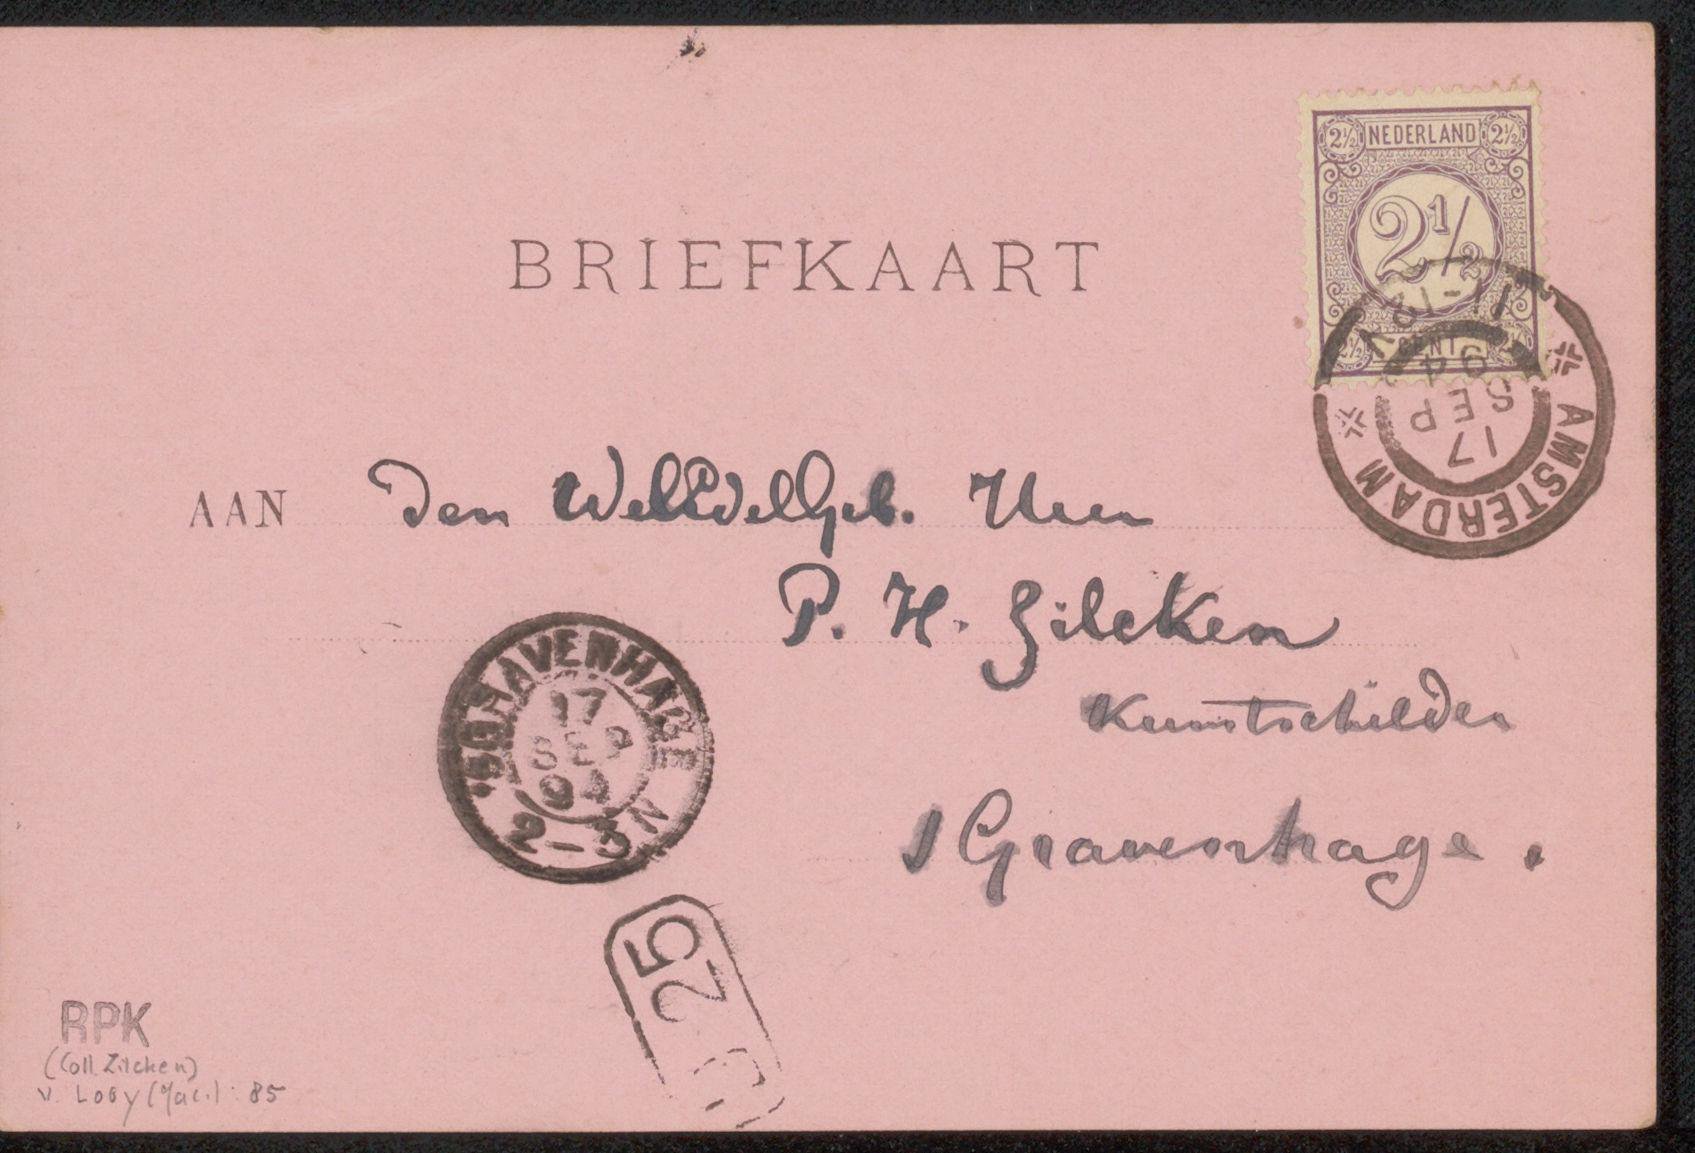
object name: postcard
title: Briefkaart aan Philip Zilcken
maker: jac van looij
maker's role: draughtsman, painter, print maker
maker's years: 1855-1930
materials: cardboard, ink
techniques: pen, writing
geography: amsterdam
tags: the hague, draughtsman, philip zilcken, art trade, art shop, drawing, printed matter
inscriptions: collector's mark: ‘RPK’